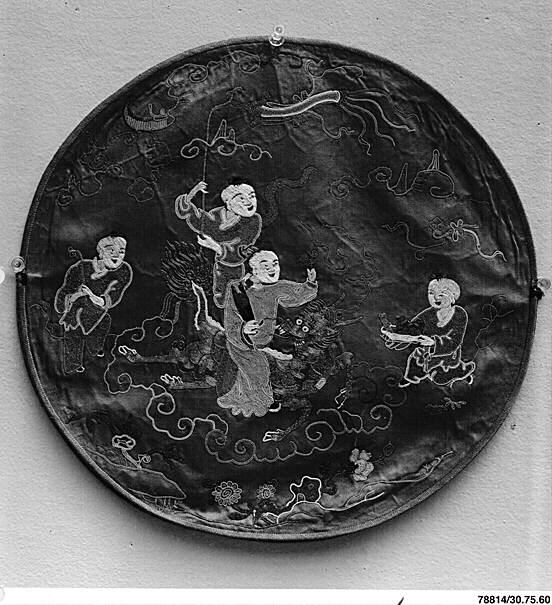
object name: mirror case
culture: chinese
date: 1801-1900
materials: metal thread, silk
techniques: embroidery, stitching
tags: men